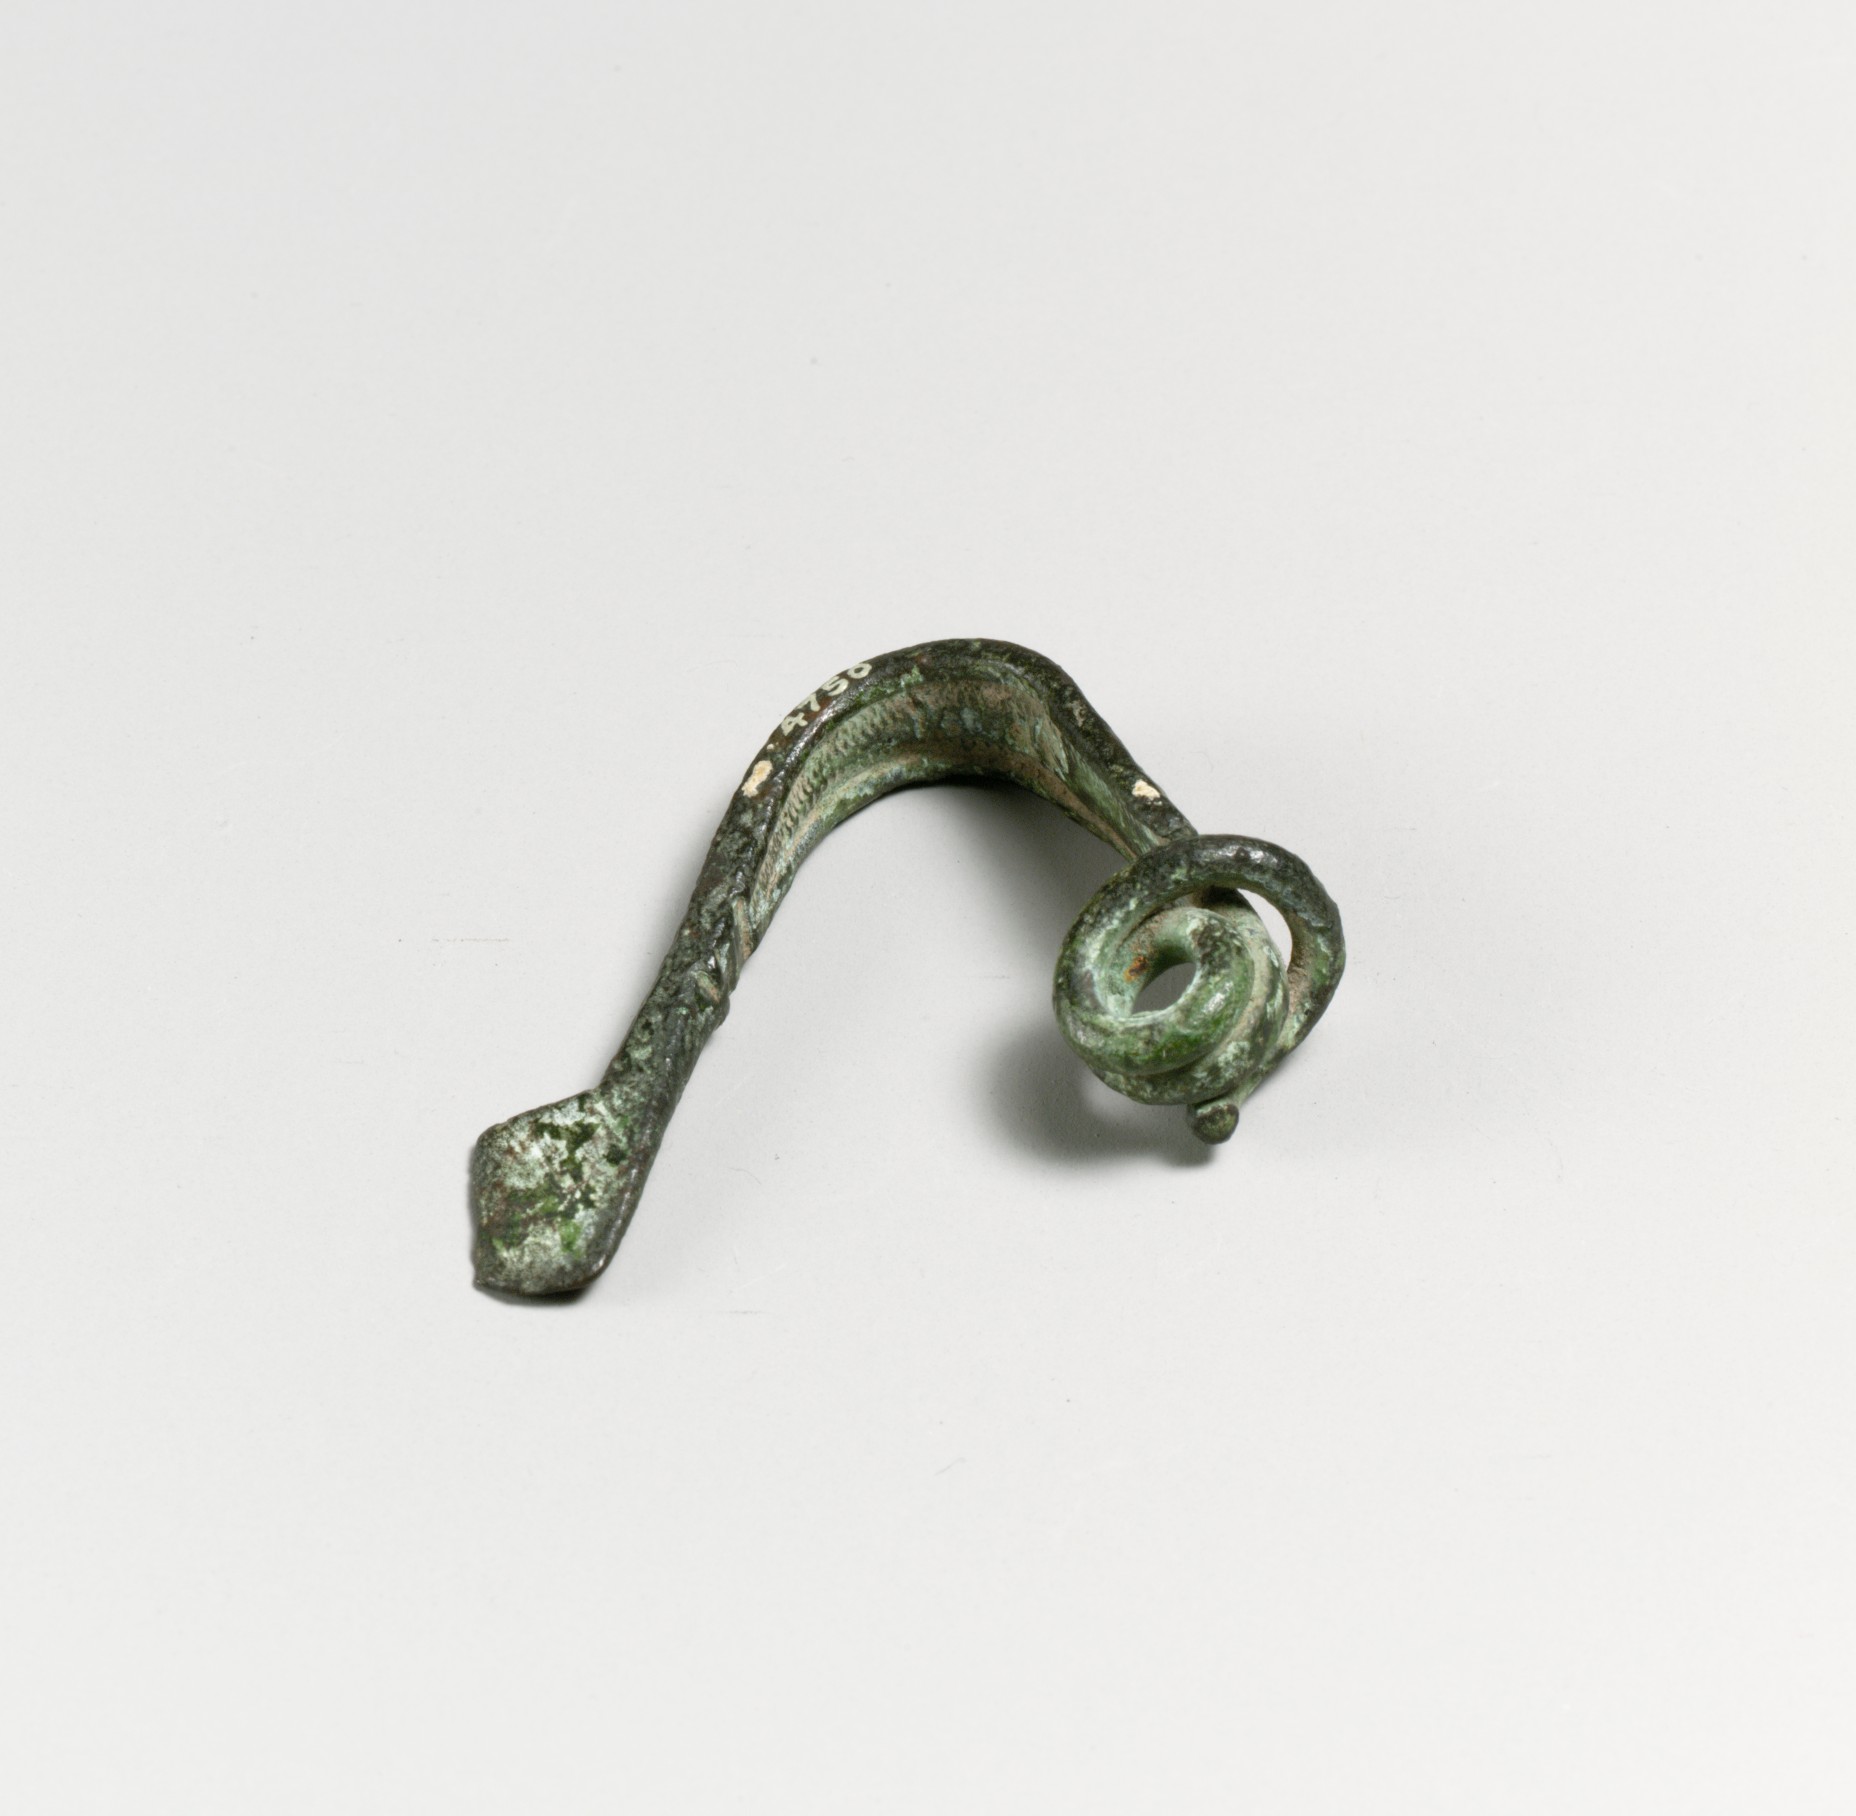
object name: fibula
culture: cypriot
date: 3900 BCE-100 CE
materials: bronze